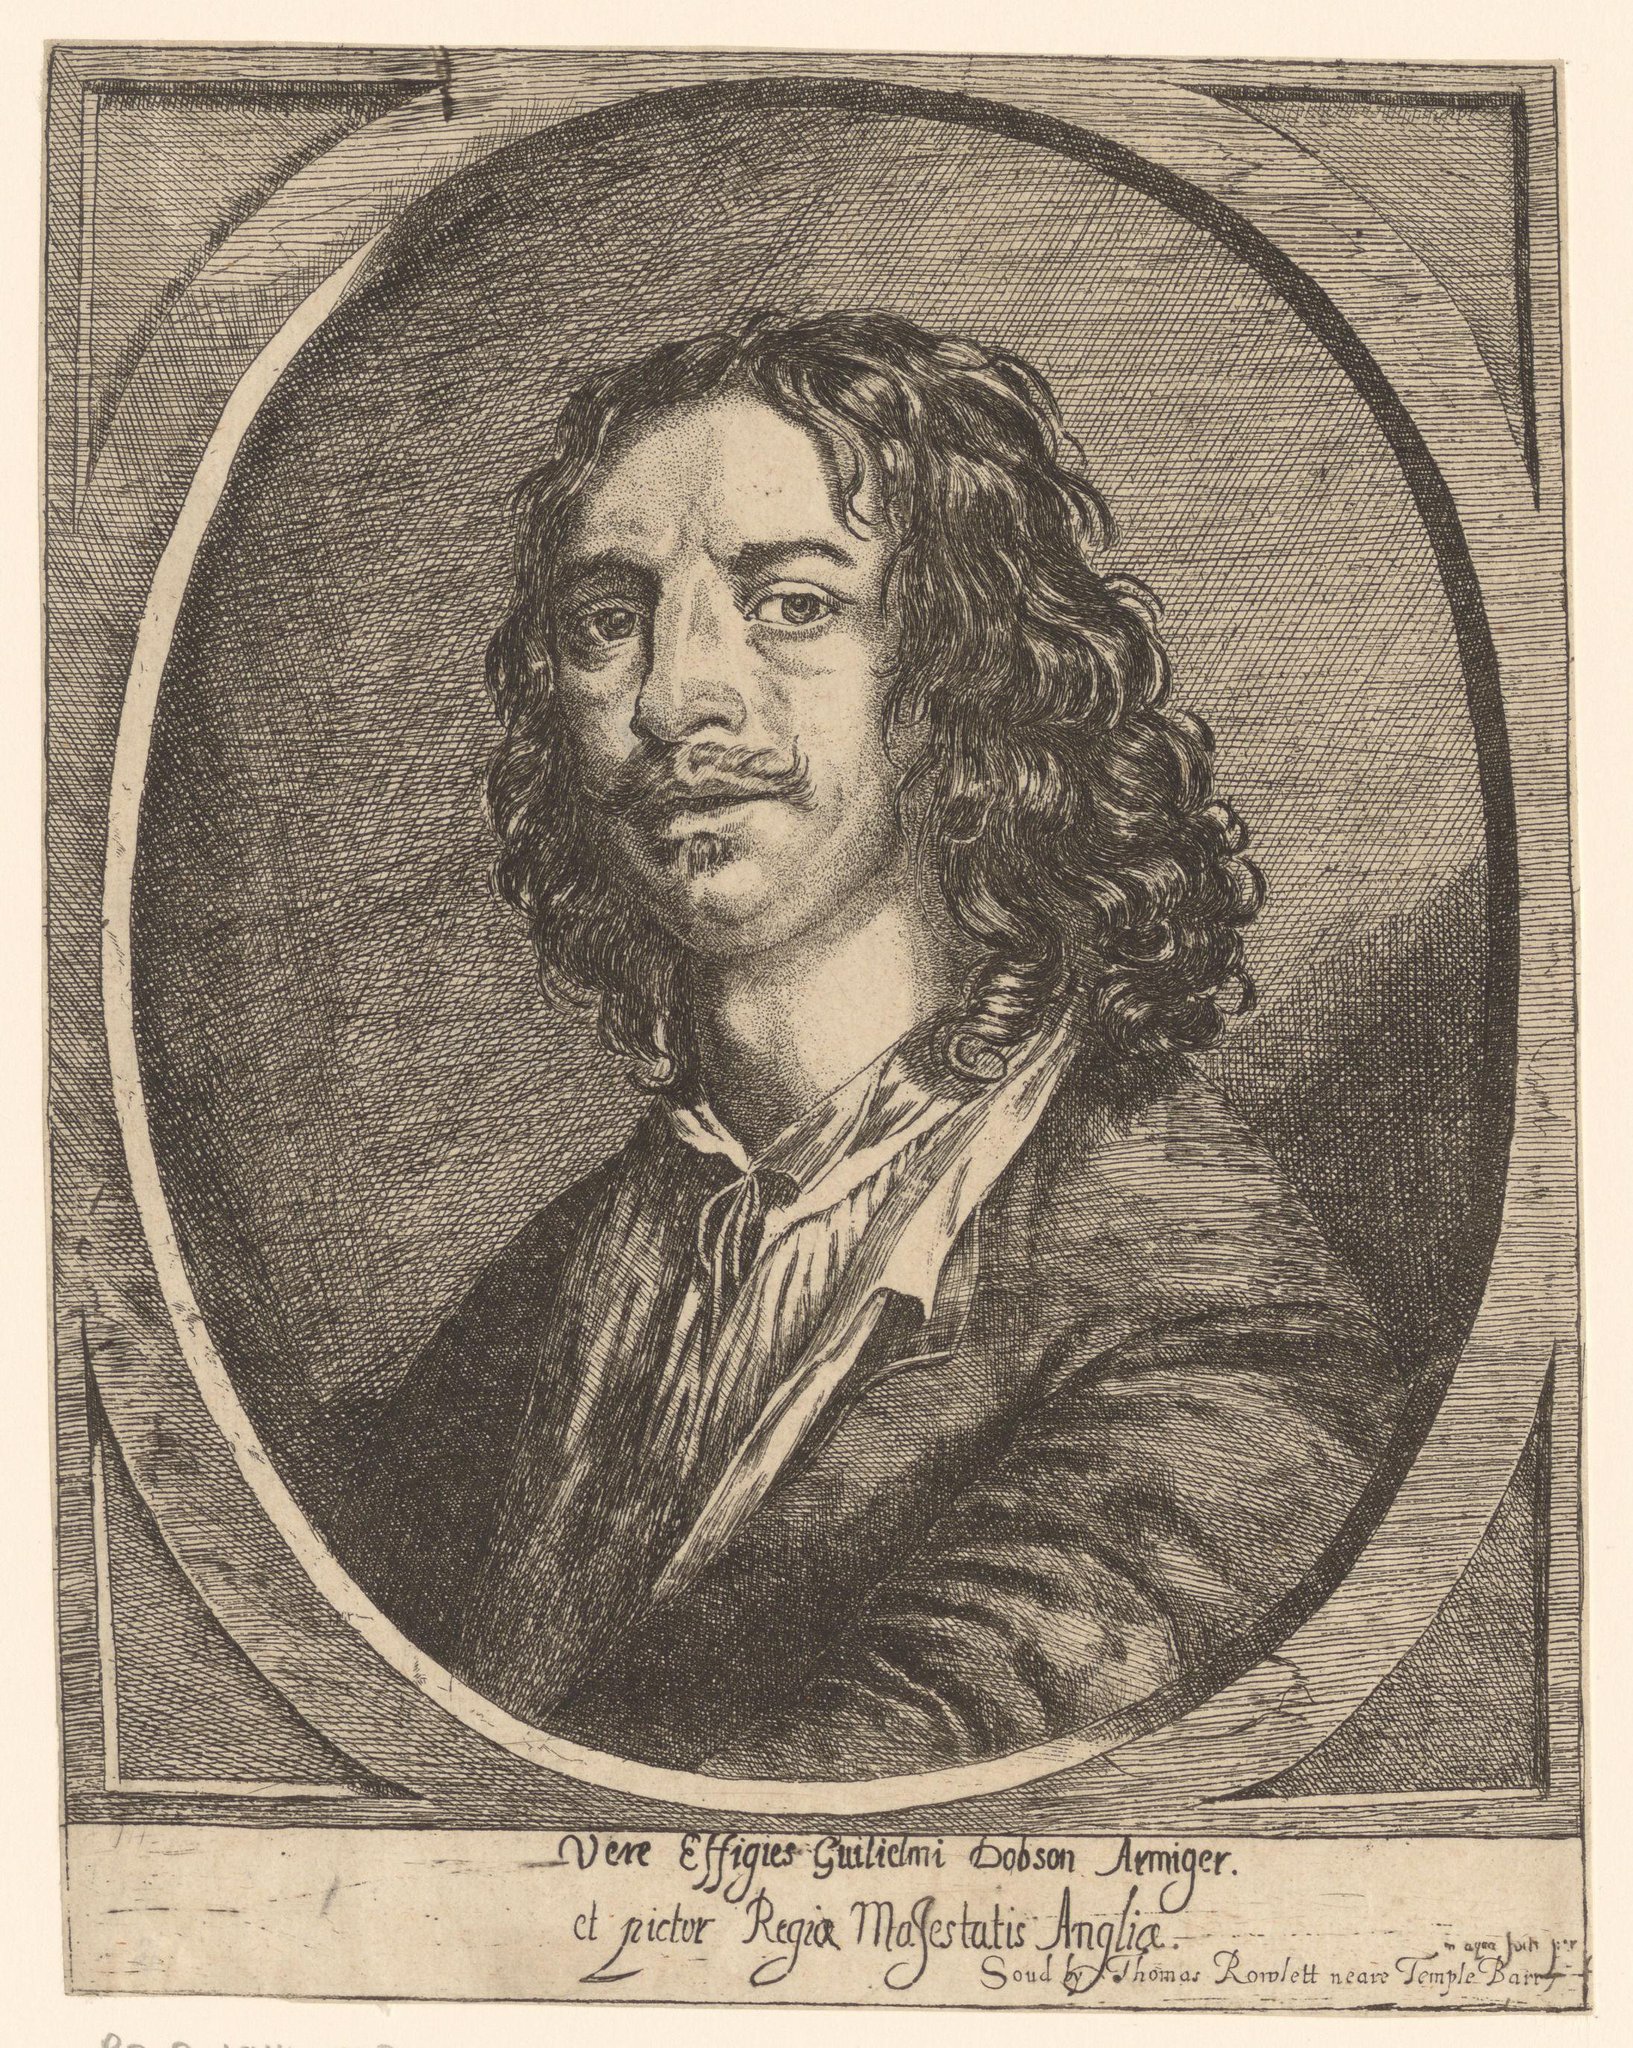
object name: print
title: Portret van William Dobson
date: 1645-1649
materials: paper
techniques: etching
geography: london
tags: london, william dobson, historical persons, portrait, self-portrait of painter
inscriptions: collector's mark: Lugt 2228, collector's mark: Lugt 2760